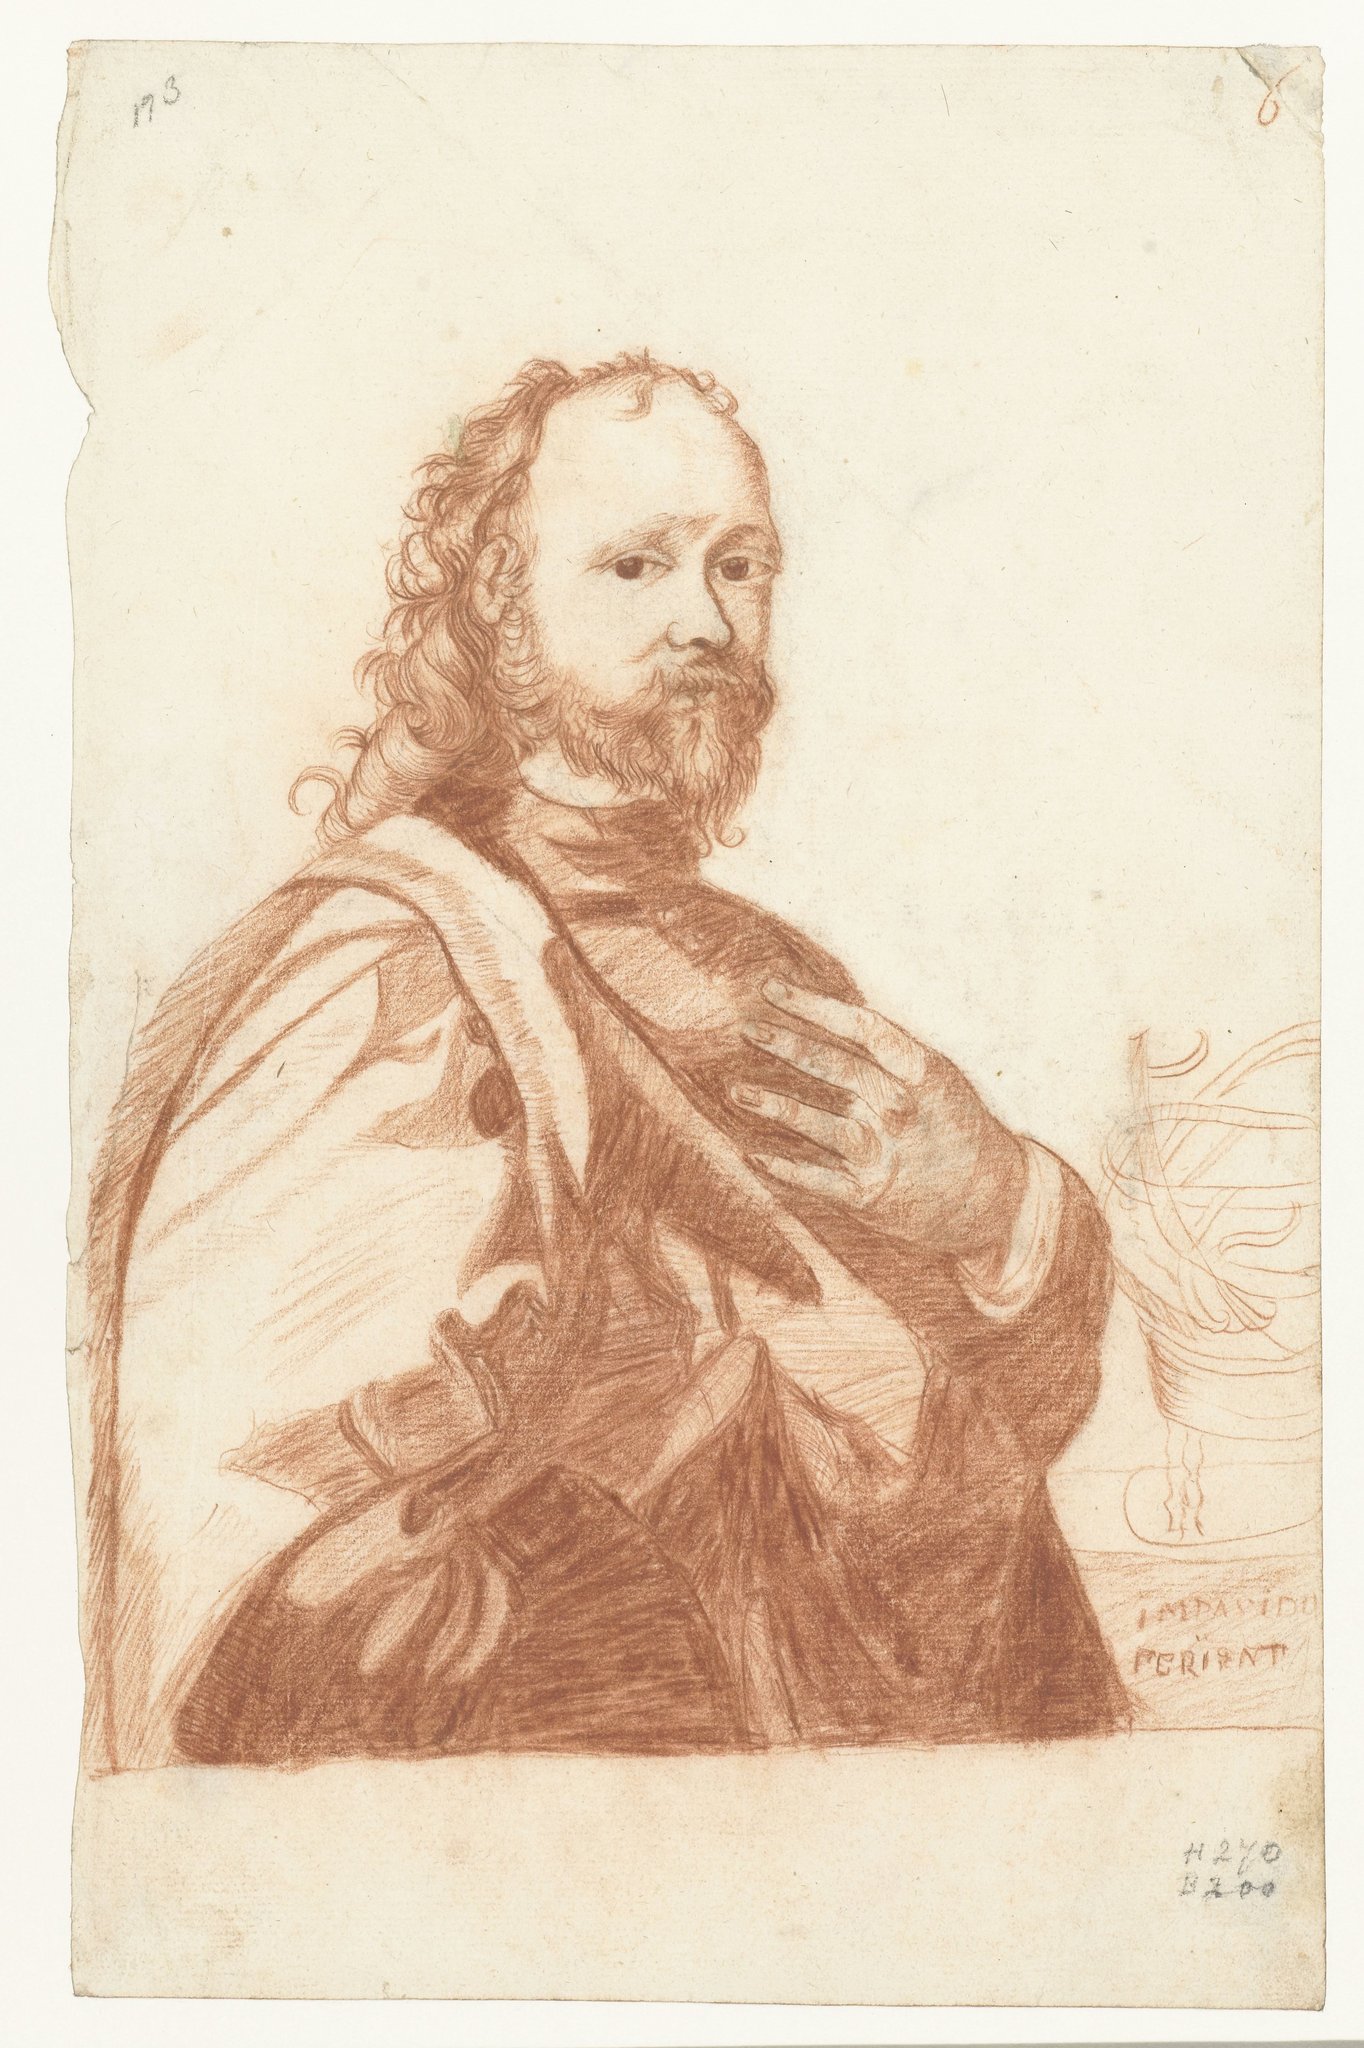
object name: drawing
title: Portret van Sir Kenelm Digby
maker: moses ter borch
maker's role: draughtsman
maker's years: 1645-1667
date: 1656-1657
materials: chalk, paper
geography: zwolle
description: Kopie naar portret van Sir Kenelm Digby gegraveerd door Moses stiefoom Robert van Voerst (voor Anthony van Dycks Iconografie).